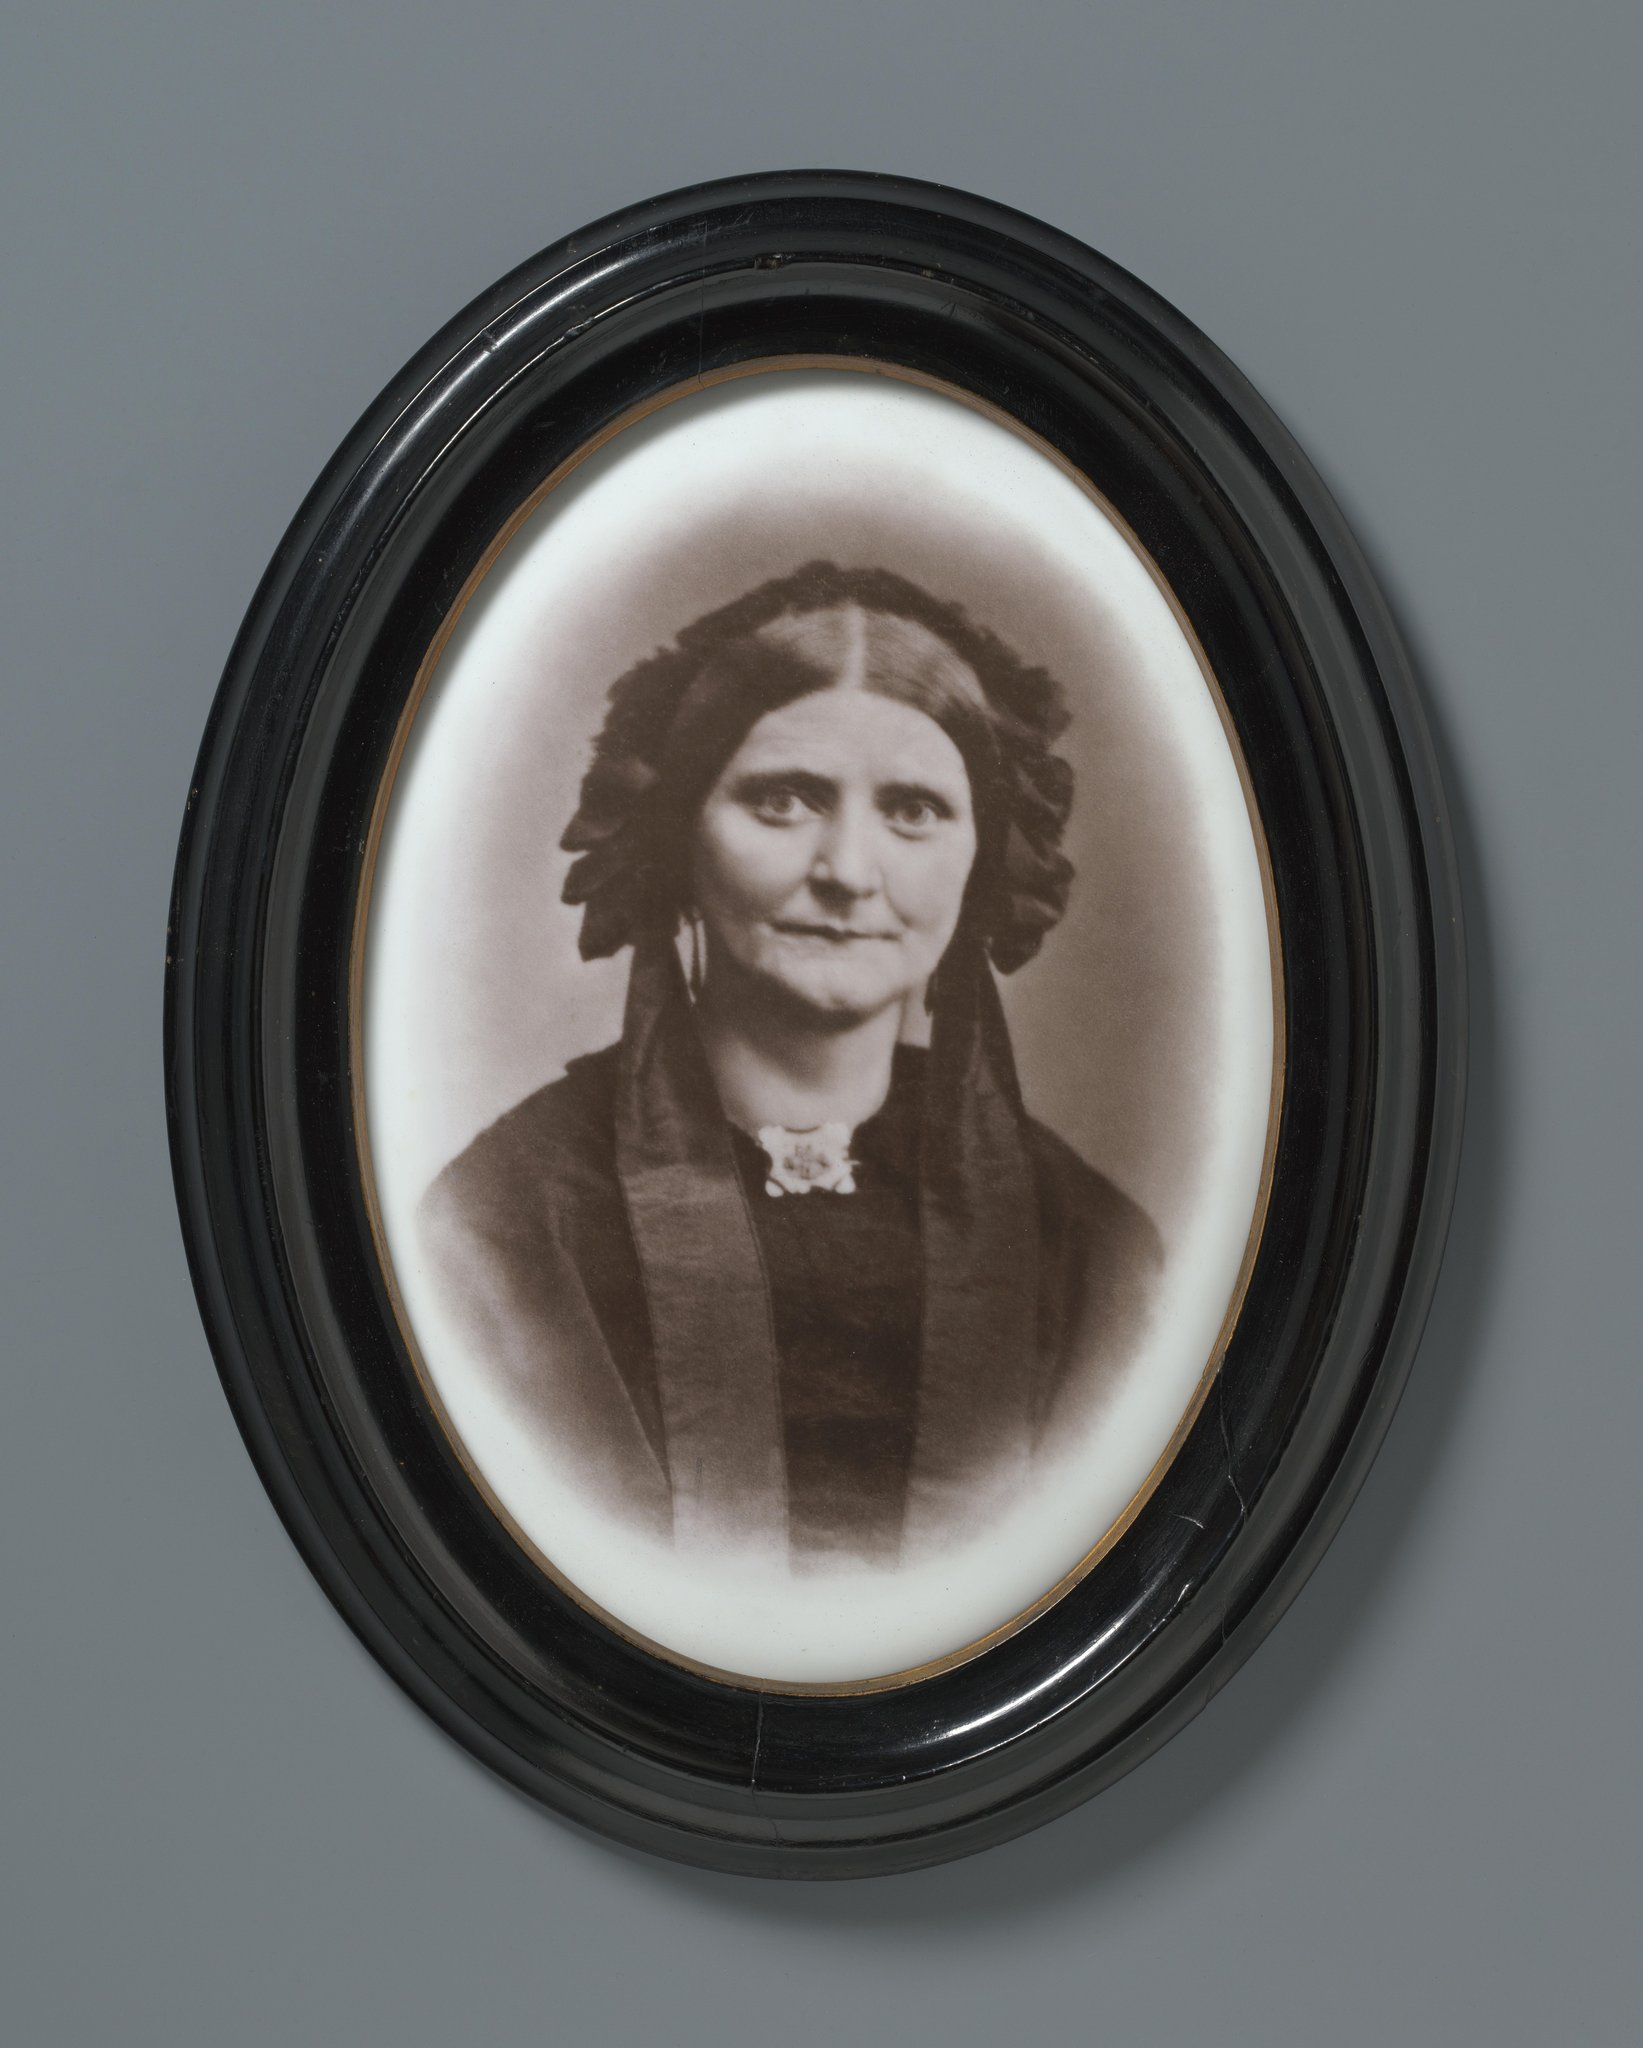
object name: frame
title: Portret van een onbekende vrouw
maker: Anonymous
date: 1895-1905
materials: cardboard, metal, porcelain, wood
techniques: porcelain photography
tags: historical persons not known by name - bb - woman